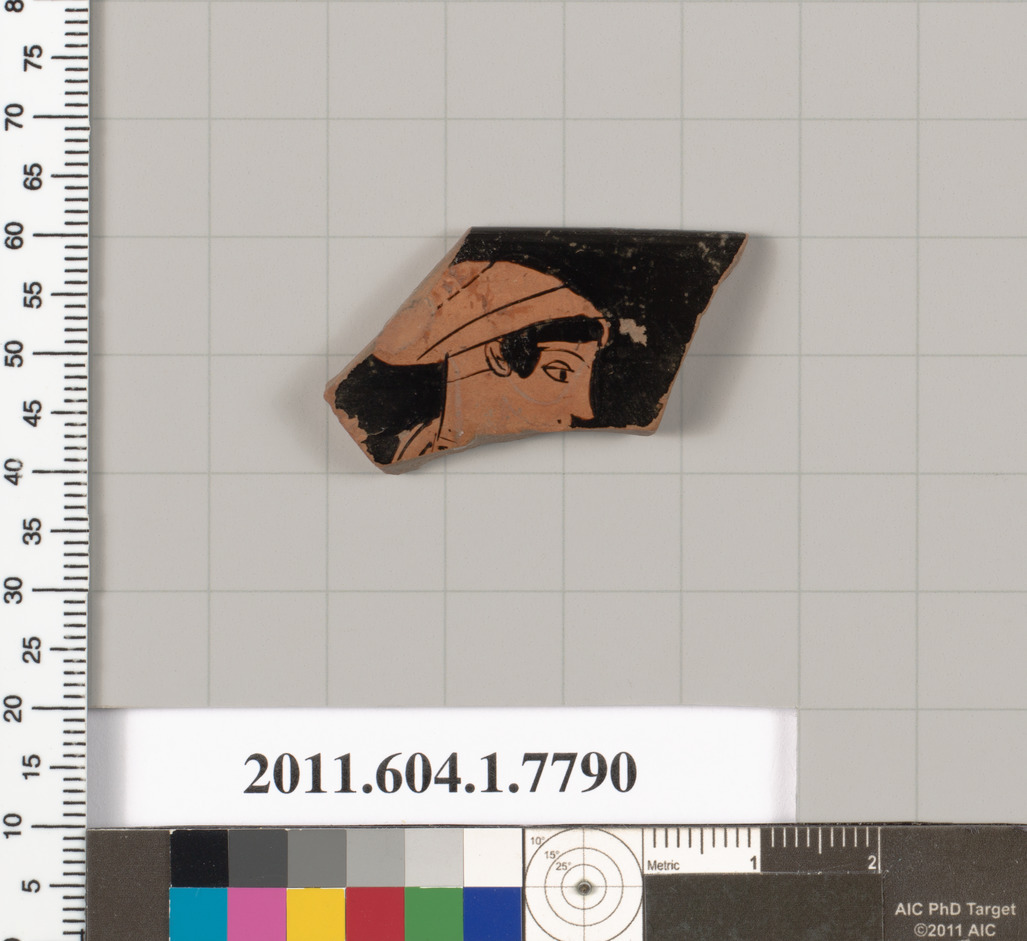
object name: kylix fragment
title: Terracotta rim fragment of a kylix (drinking cup)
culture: greek, attic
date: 460-450 BCE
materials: terracotta